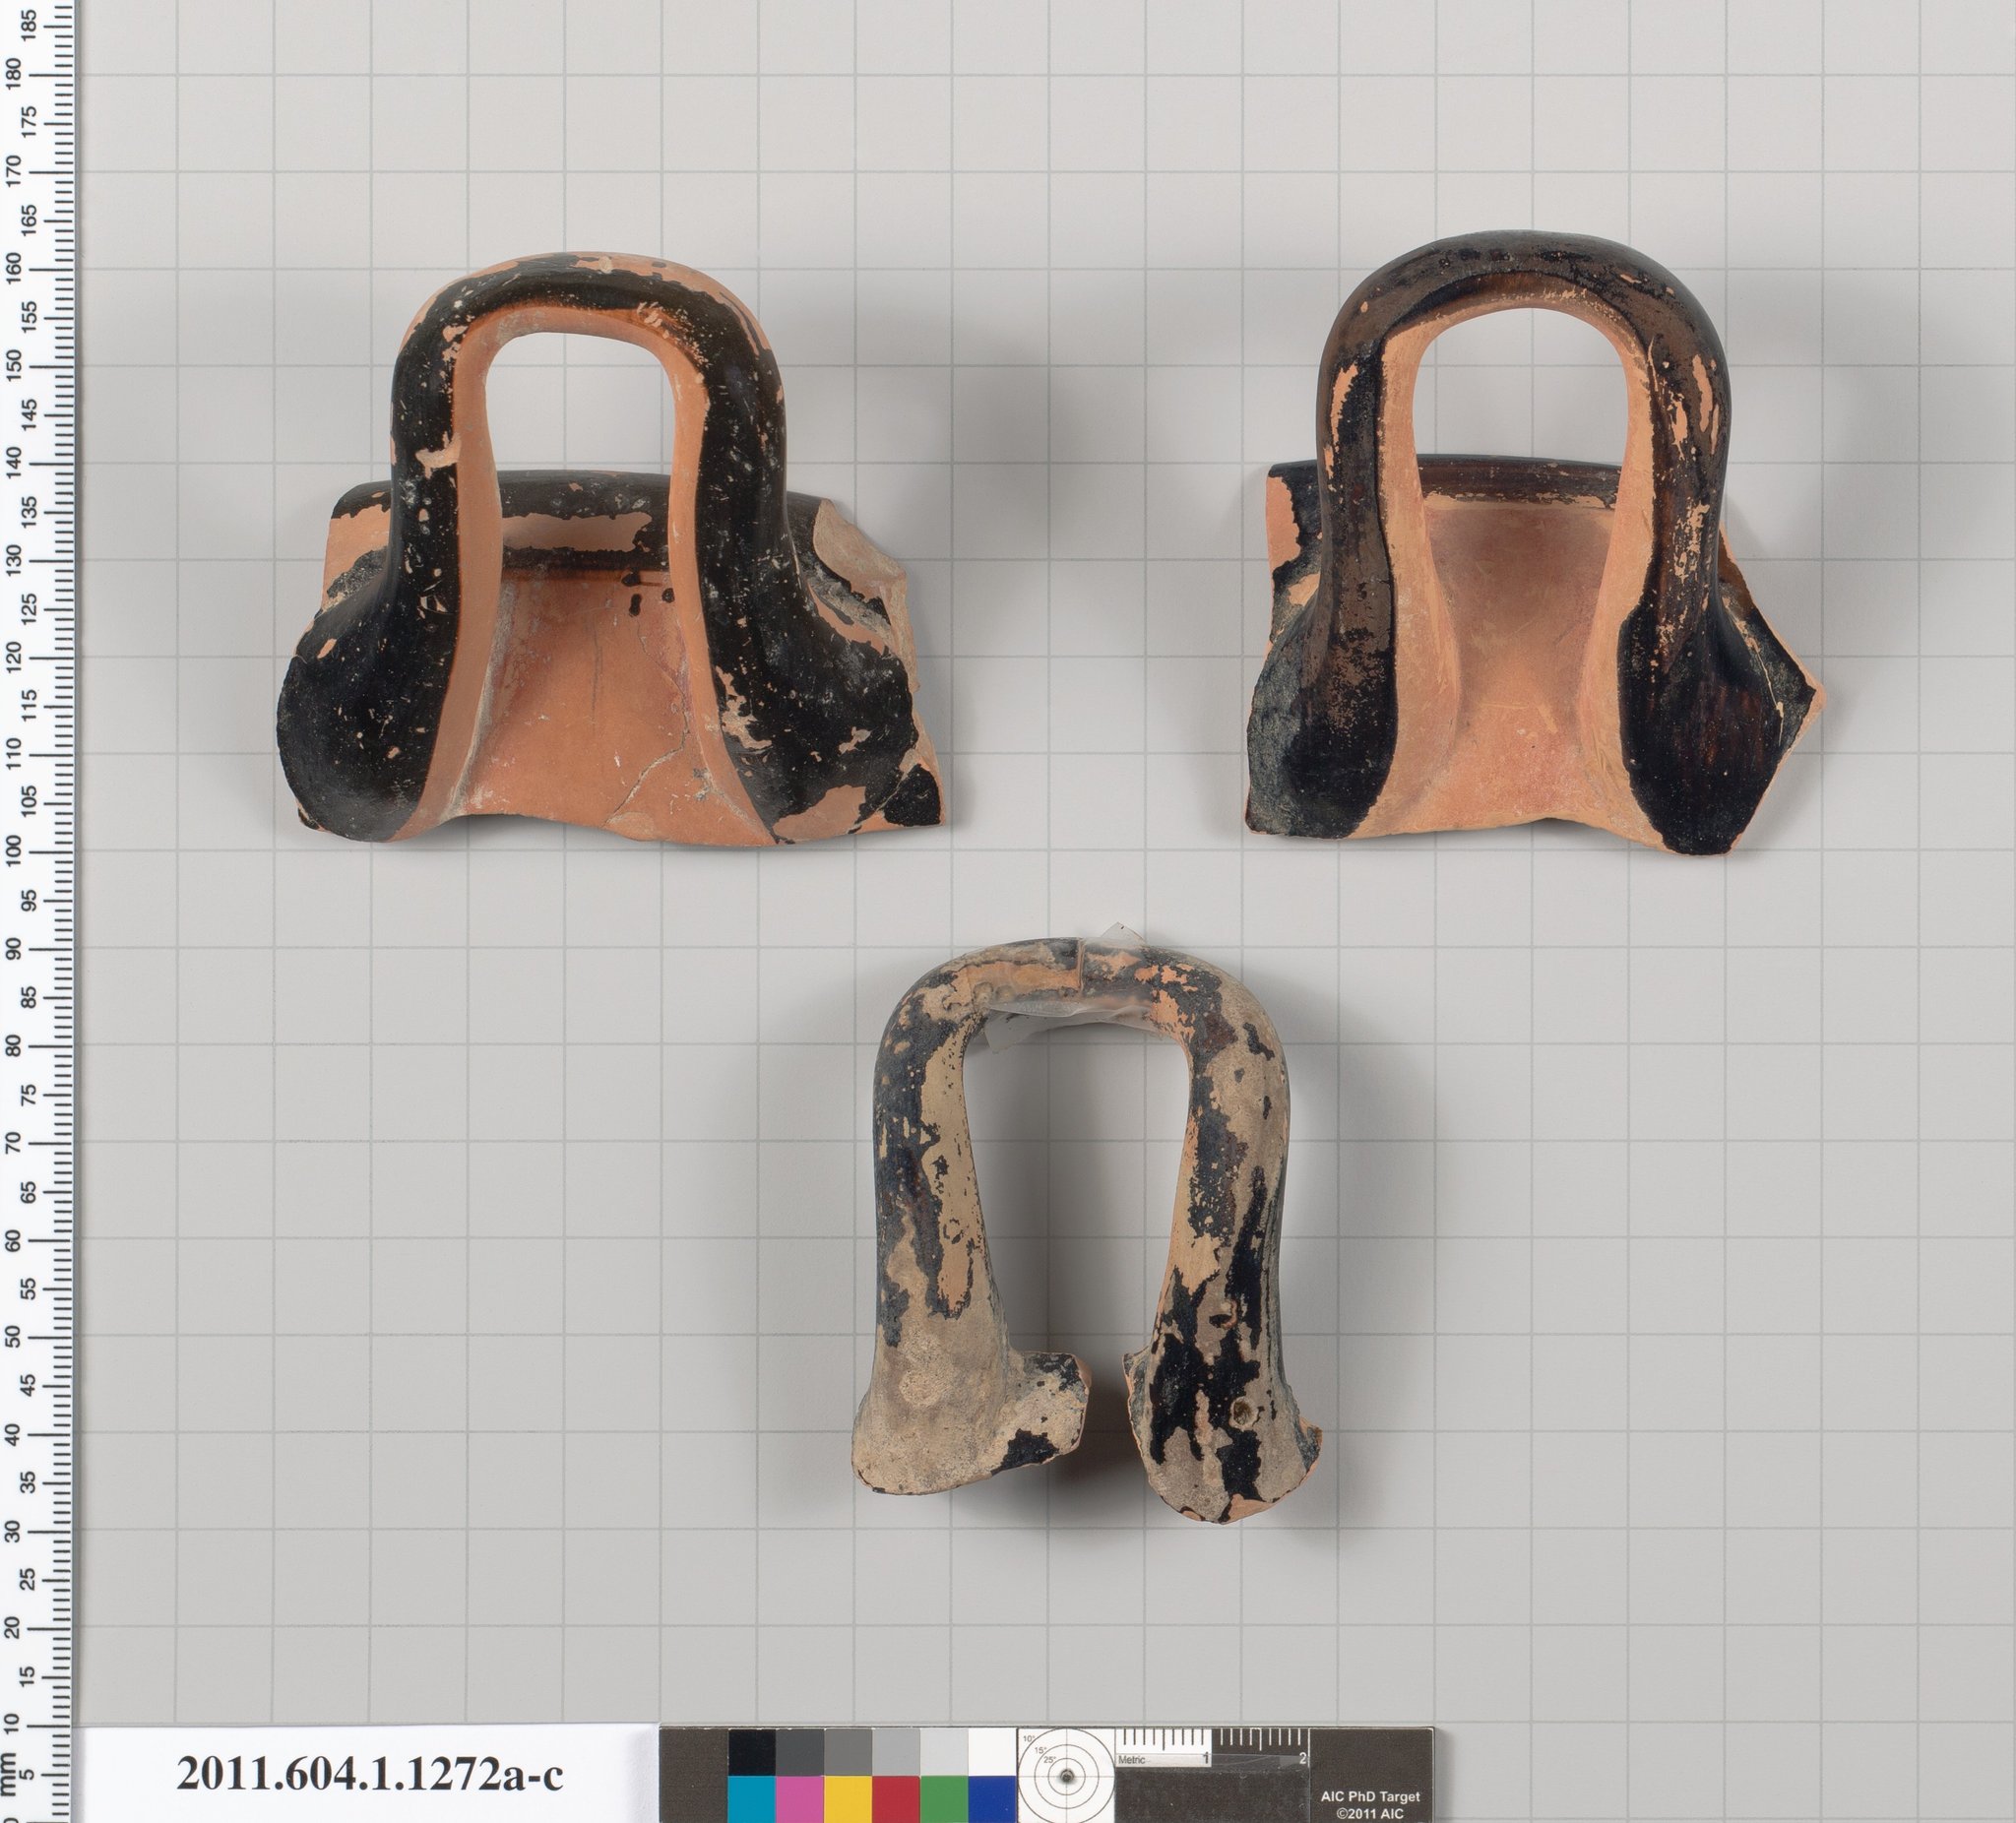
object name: kylix fragment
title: Terracotta fragments of kylikes (drinking cups)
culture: greek, attic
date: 500-401 BCE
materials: terracotta